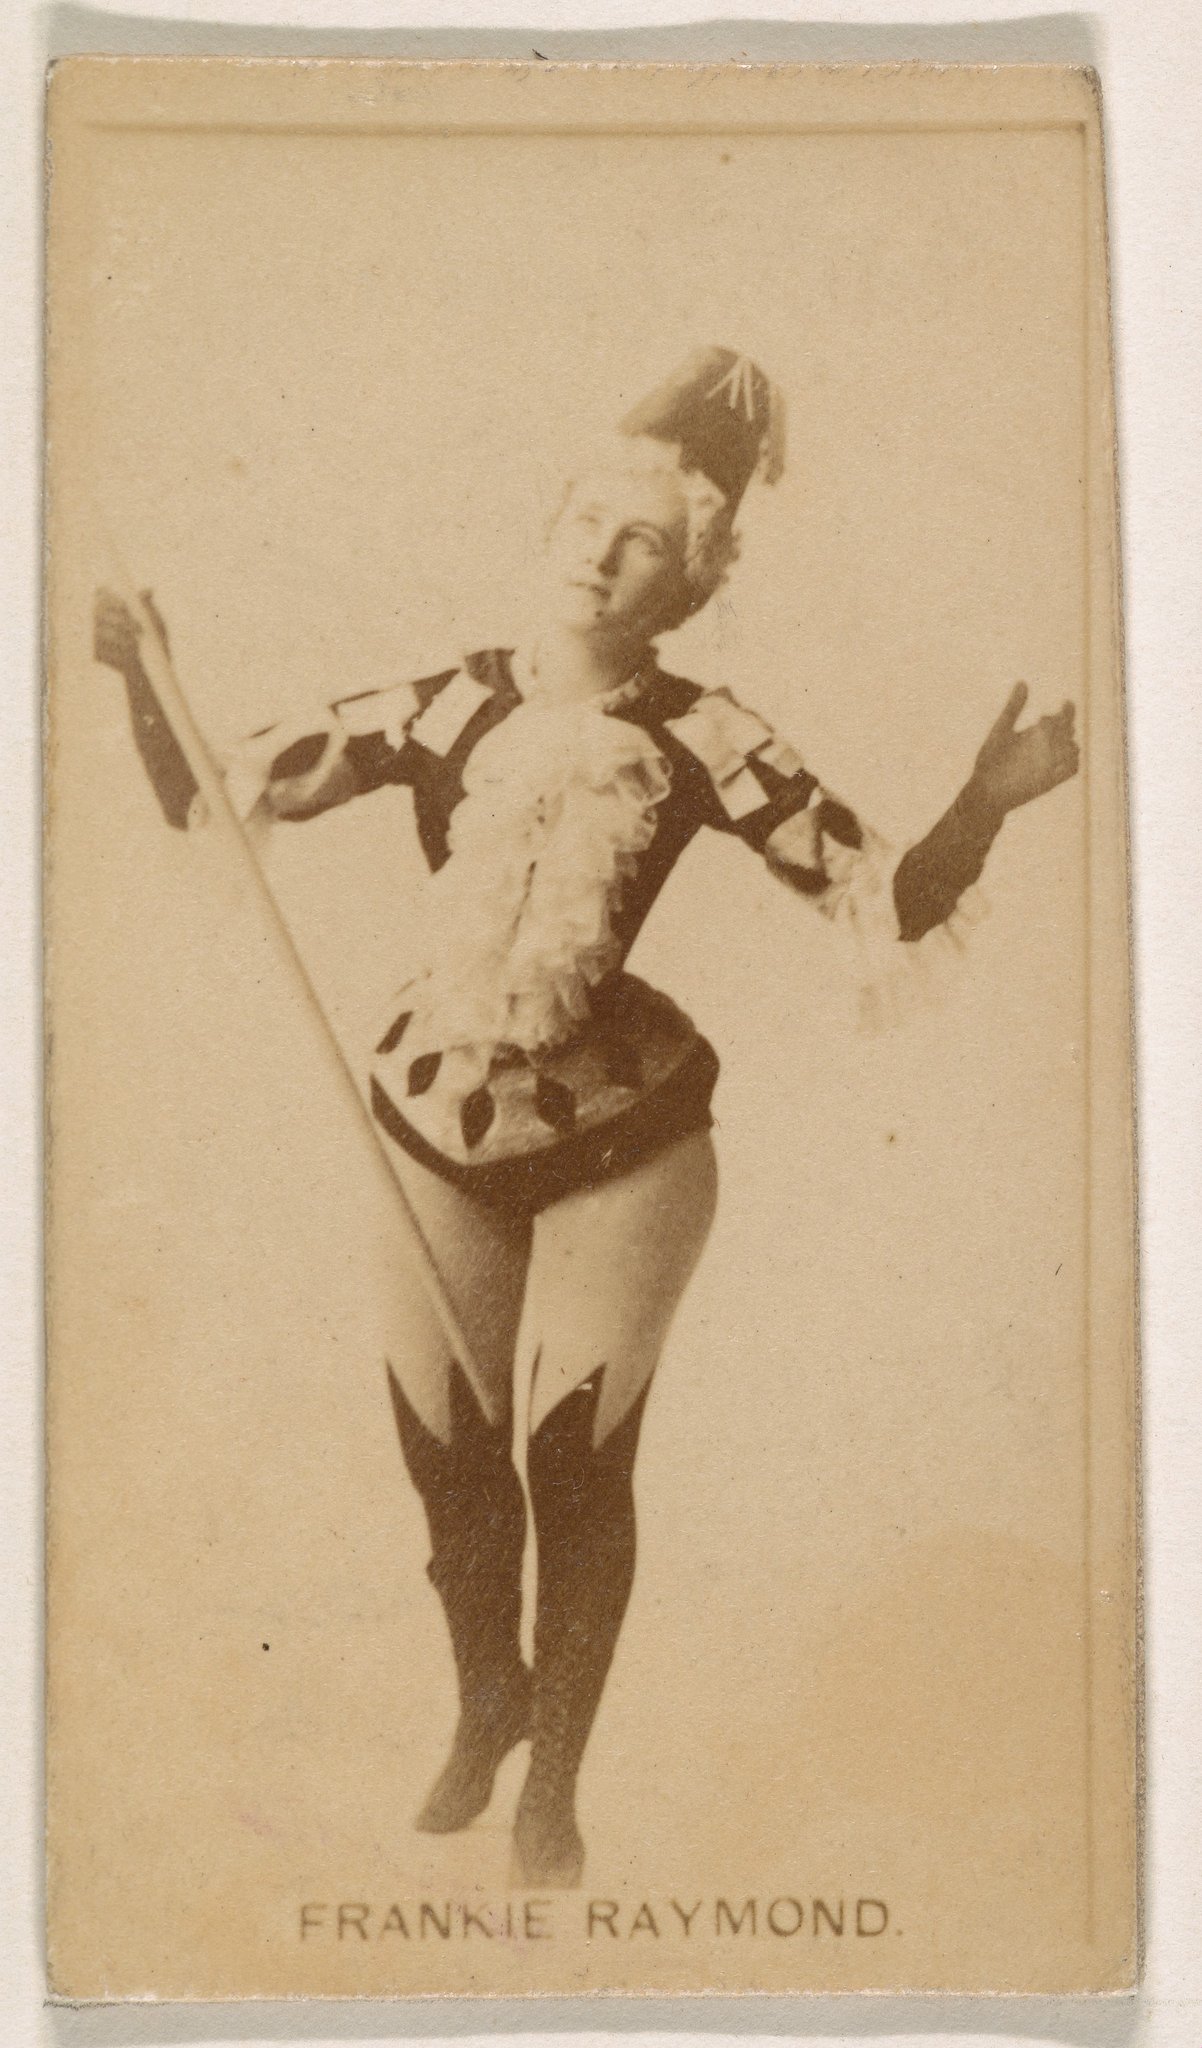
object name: photograph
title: Frankie Raymond, from the Actresses series (N245) issued by Kinney Brothers to promote Sweet Caporal Cigarettes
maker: kinney brothers tobacco company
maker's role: publisher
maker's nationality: american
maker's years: 1869-2011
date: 1890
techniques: albumen silver print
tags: portraits,women,actresses